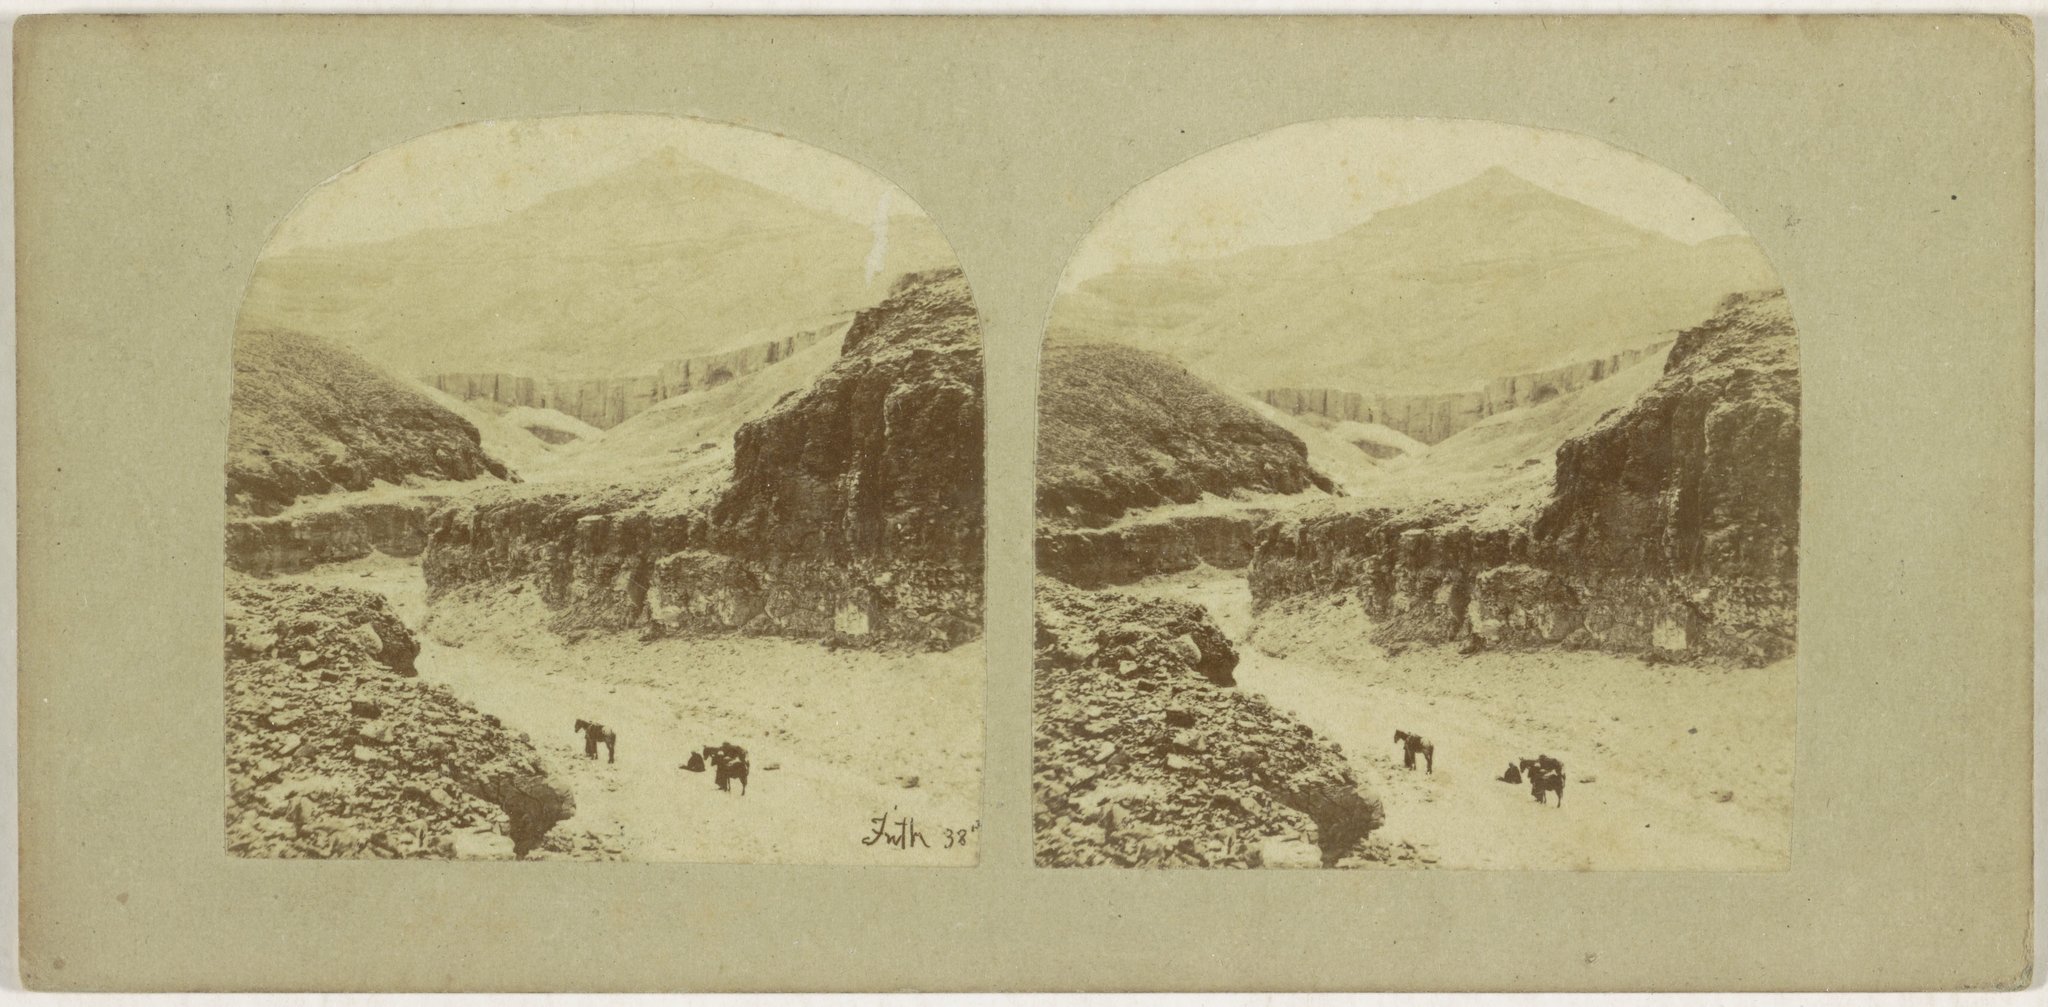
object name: stereograph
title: Views in Egypt and Nubia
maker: francis frith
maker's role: publisher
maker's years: 1822-1898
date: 1857-1859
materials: cardboard, paper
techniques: albumen print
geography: london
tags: ancient grave forms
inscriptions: number: ‘38 [...]’, inscription: ‘[Deposé.’, inscription: ‘It is impractible to exhibit the entrance to any of the tombs in any good general view of (...)’, number: ‘337’, inscription: ‘Entered at Stationers' Hall.]’, inscription: ‘1e Negretti en Zambra uitgever film Frith (1857-58)’